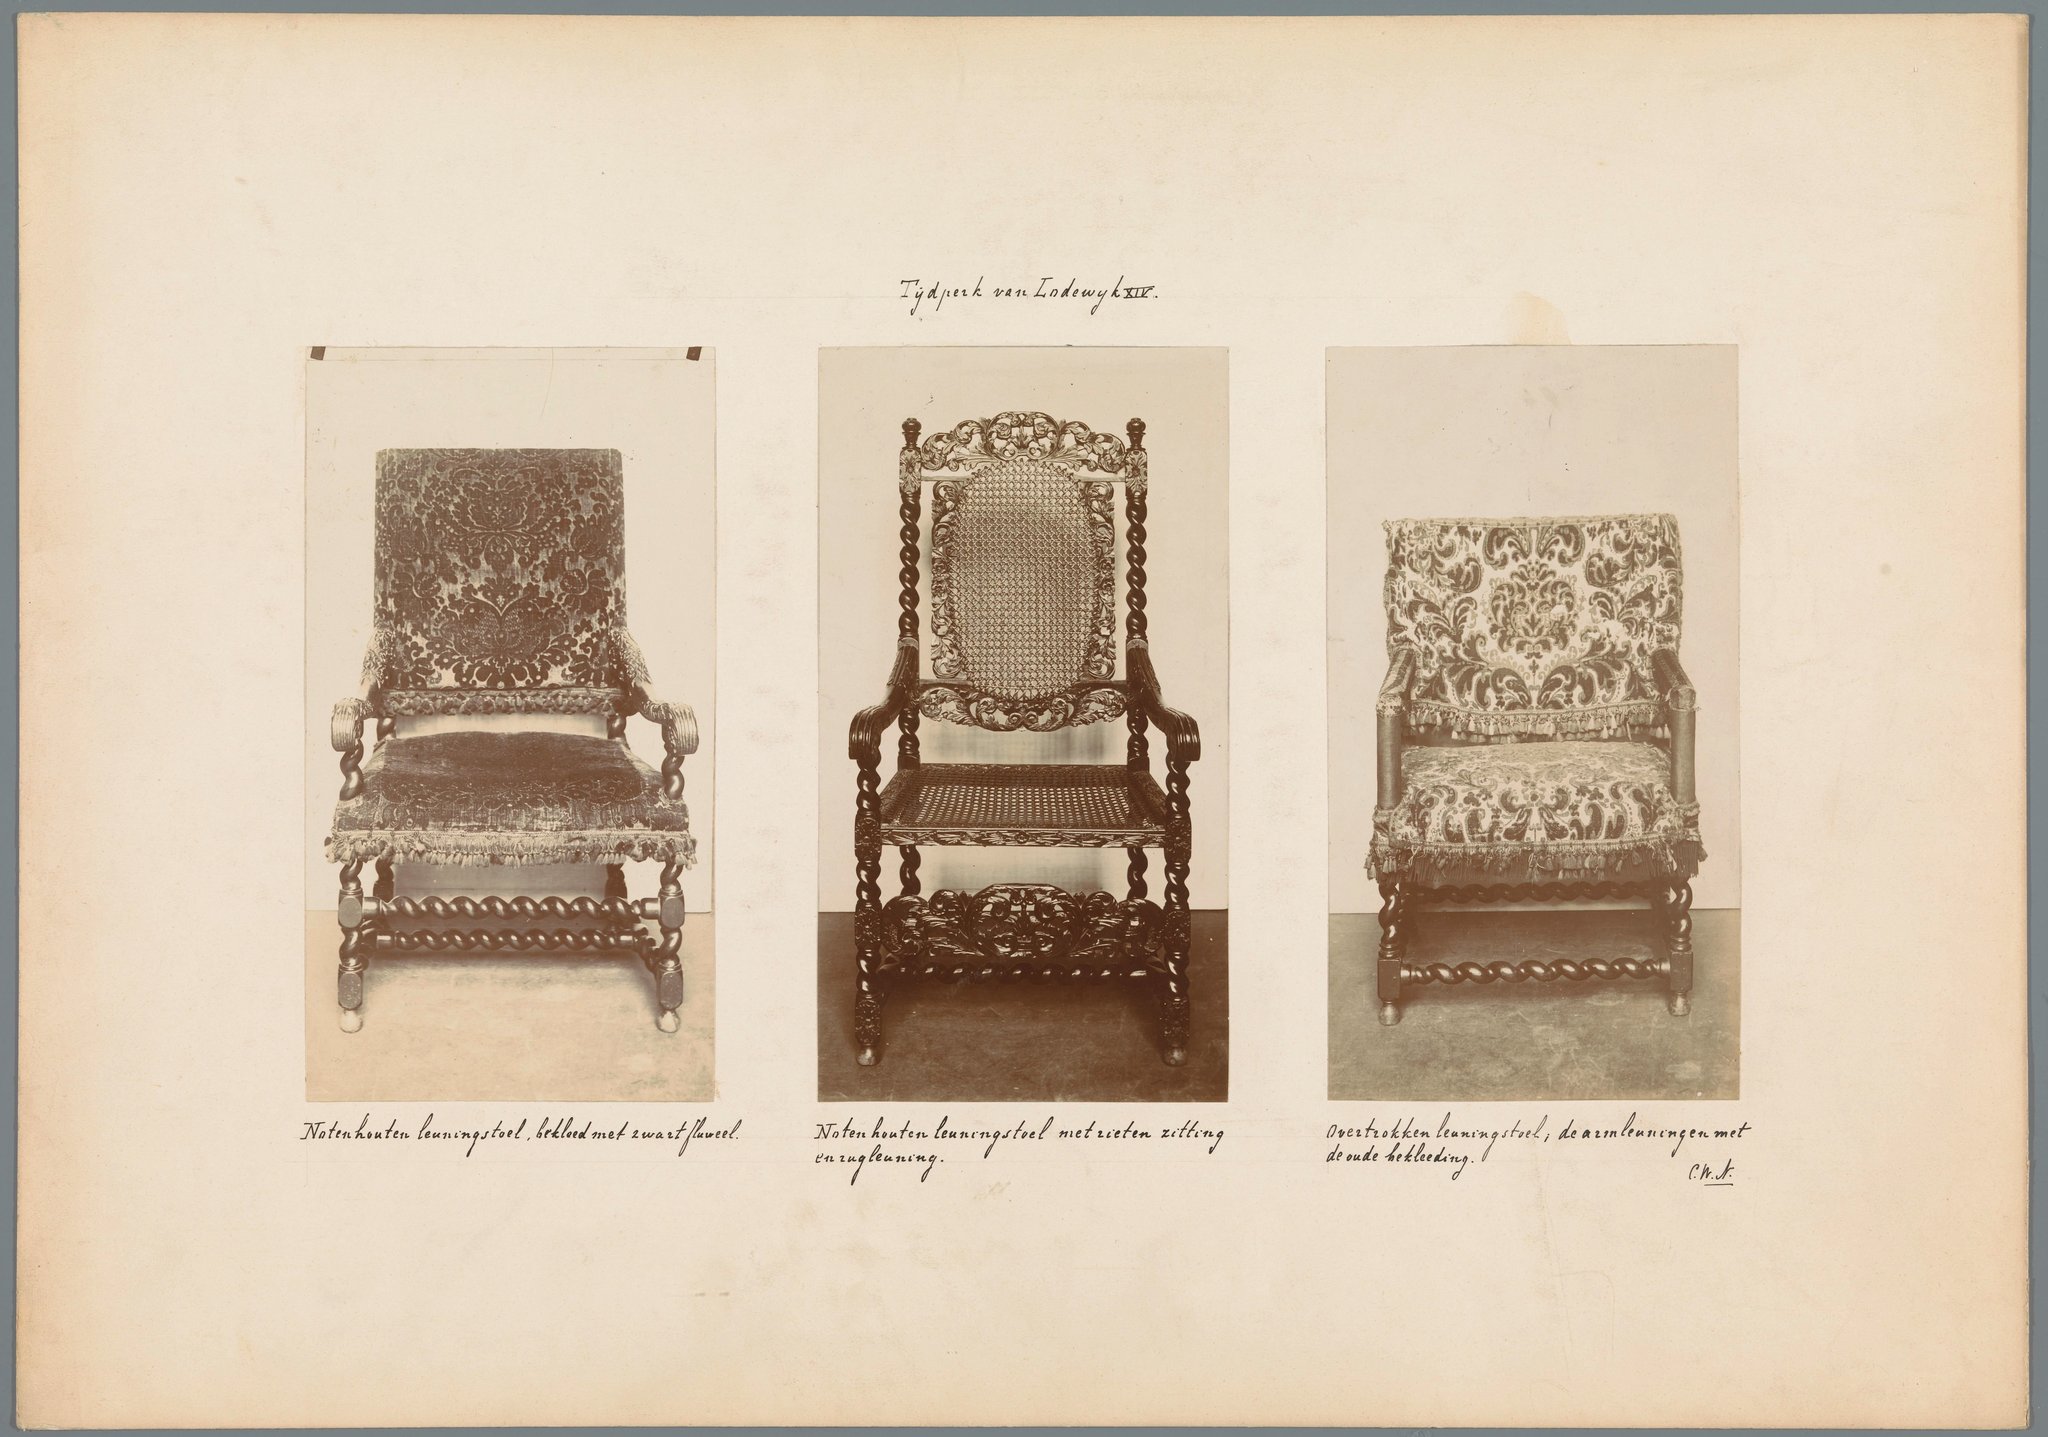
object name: photograph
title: Drie stoelen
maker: Anonymous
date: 1875-1900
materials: cardboard, photographic support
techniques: gelatin silver print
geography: europe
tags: chair, europe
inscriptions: collector's mark: ‘INSTITUUT VOOR KUNST-NIJVERHEIDSONDERWIJS GABRIËL METSUSTRAAT No. 16 AMSTERDAM’, collector's mark: ‘KUNSTNIJVERHEIDSCHOOL QUELLINUS AMSTERDAM FRANS HALSSTRAAT 14.’, inscription: ‘Tijdperk van Lodewijk XIV.’, inscription: ‘C.W.N.’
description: Links een armstoel bekleed met fluweel, midden een armstoel waarvan de geslingerde rugstijlen worden bekroond door gedraaide vazen, rechts een armstoel met geslingerde spijlen.